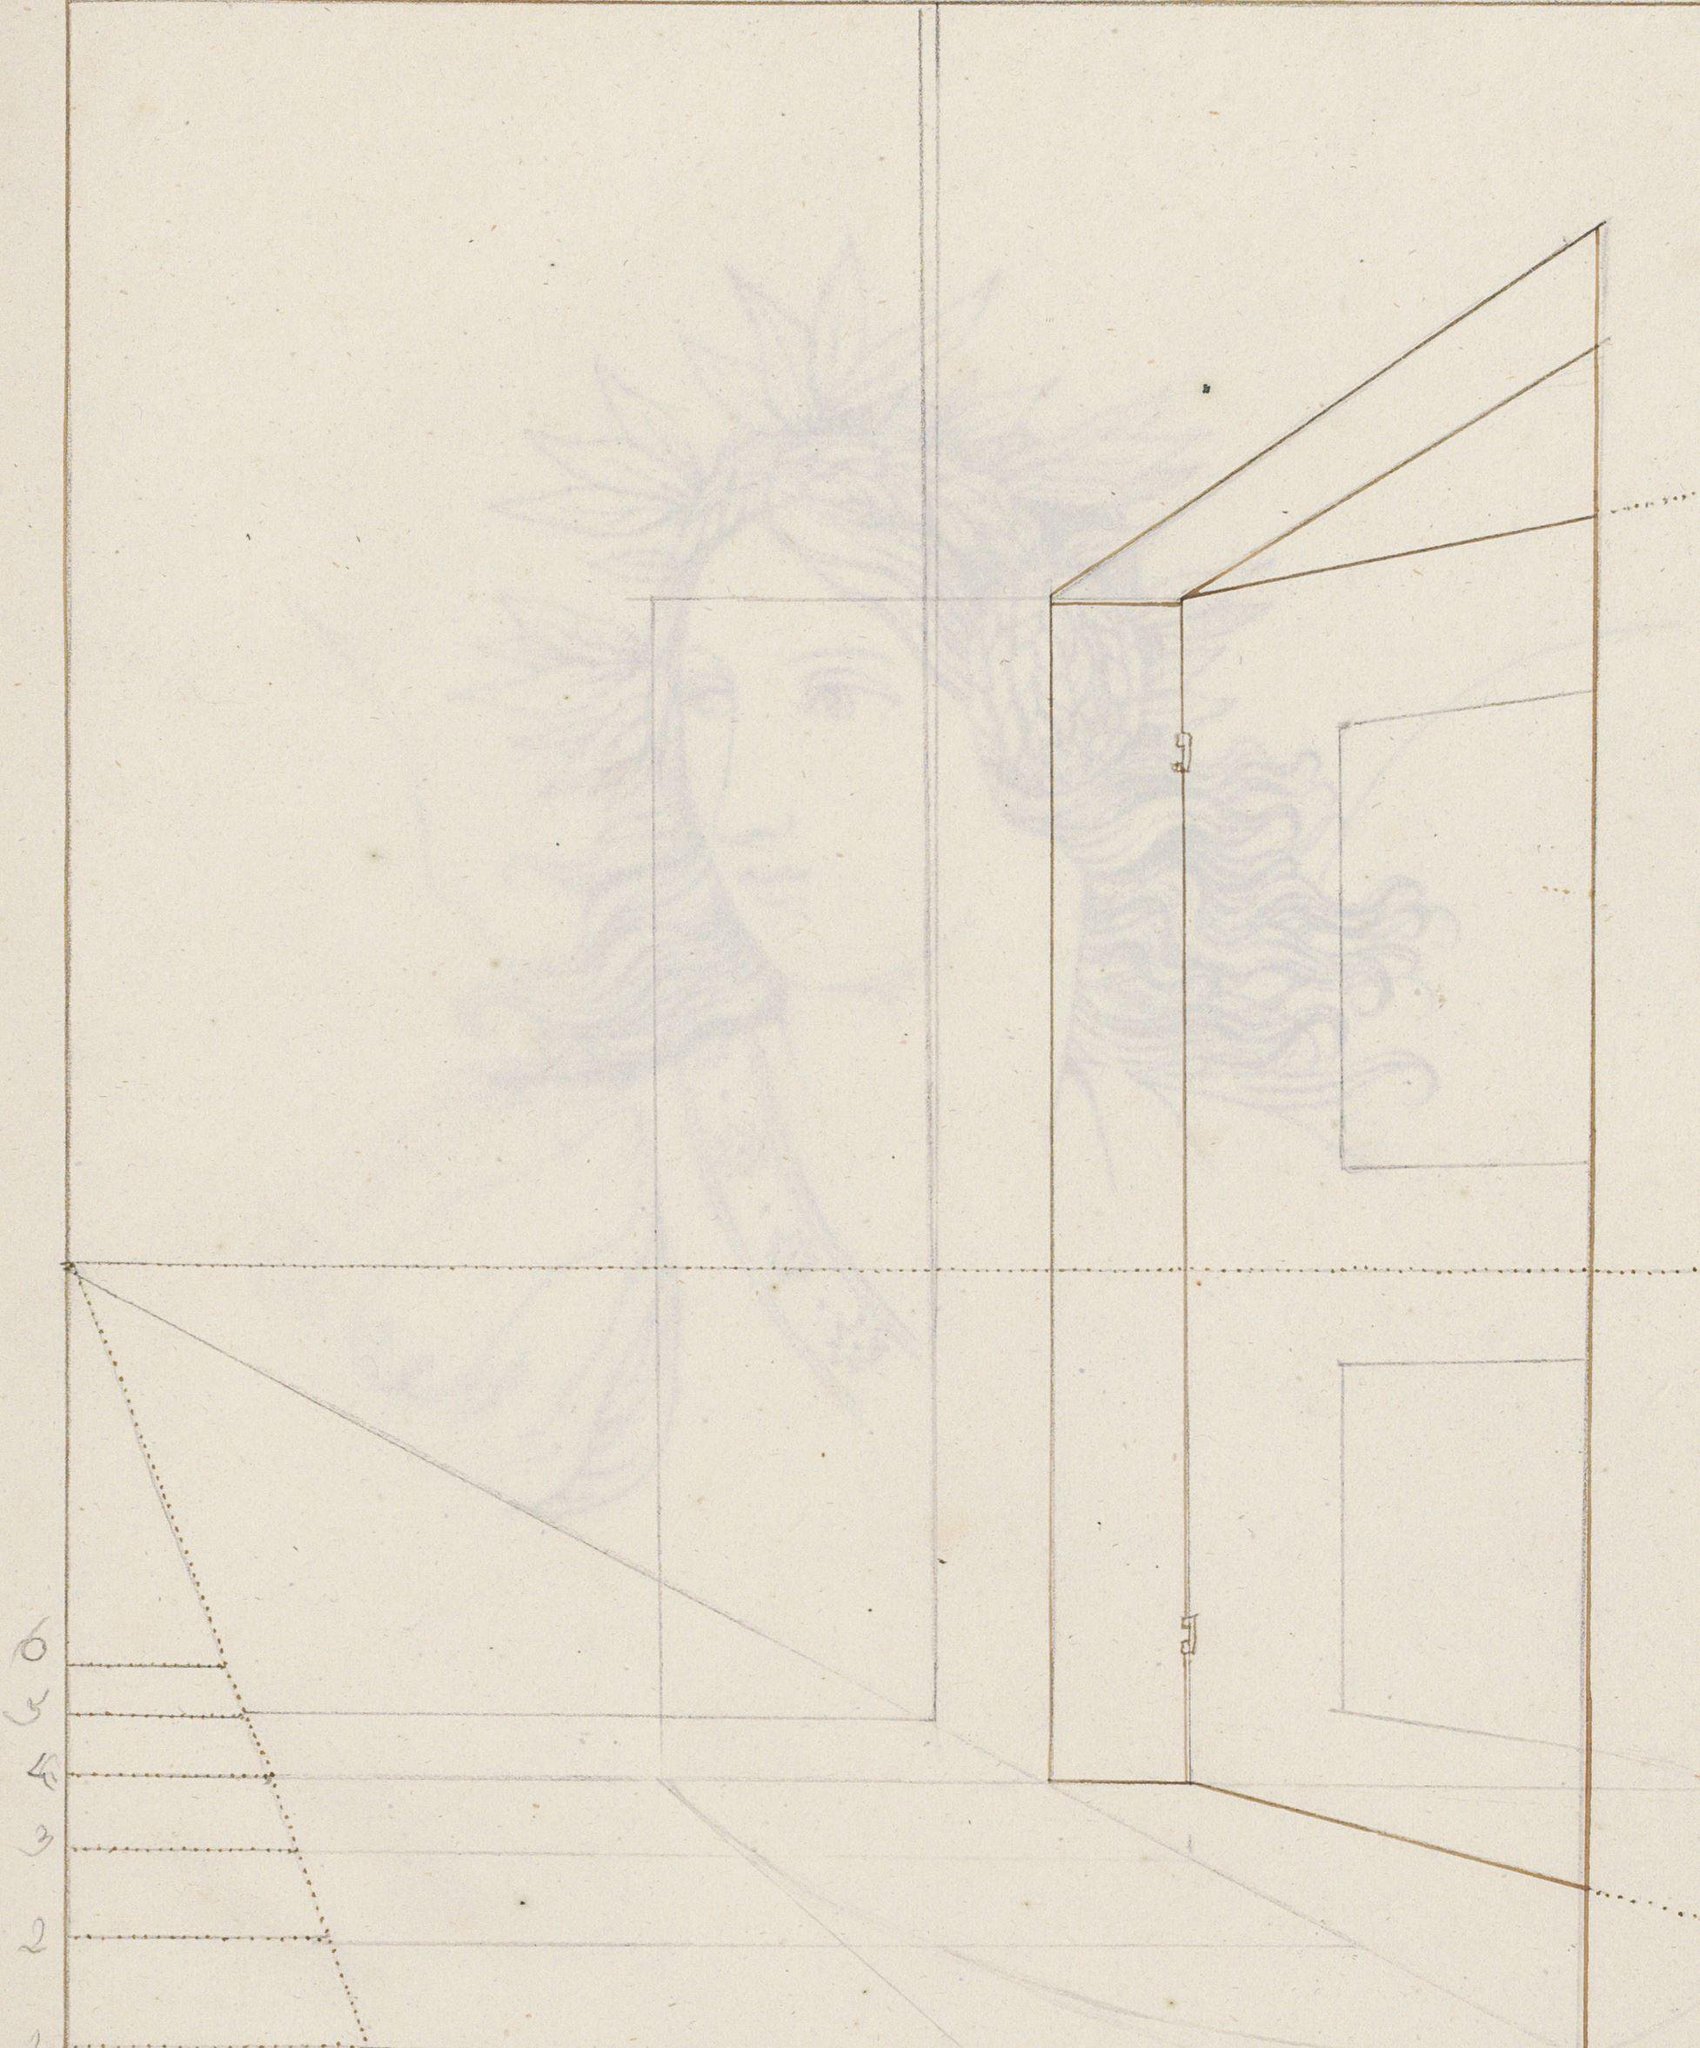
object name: sketchbook leaf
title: Perspectiefoefening met een open deur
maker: jonkvrouw elisabeth kemper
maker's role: draughtsman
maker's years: 1799-1871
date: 1815-1852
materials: ink, paper, pencil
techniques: pen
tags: open door, mathematical perspective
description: Blad 30 recto uit een schetsboek met 94 bladen.